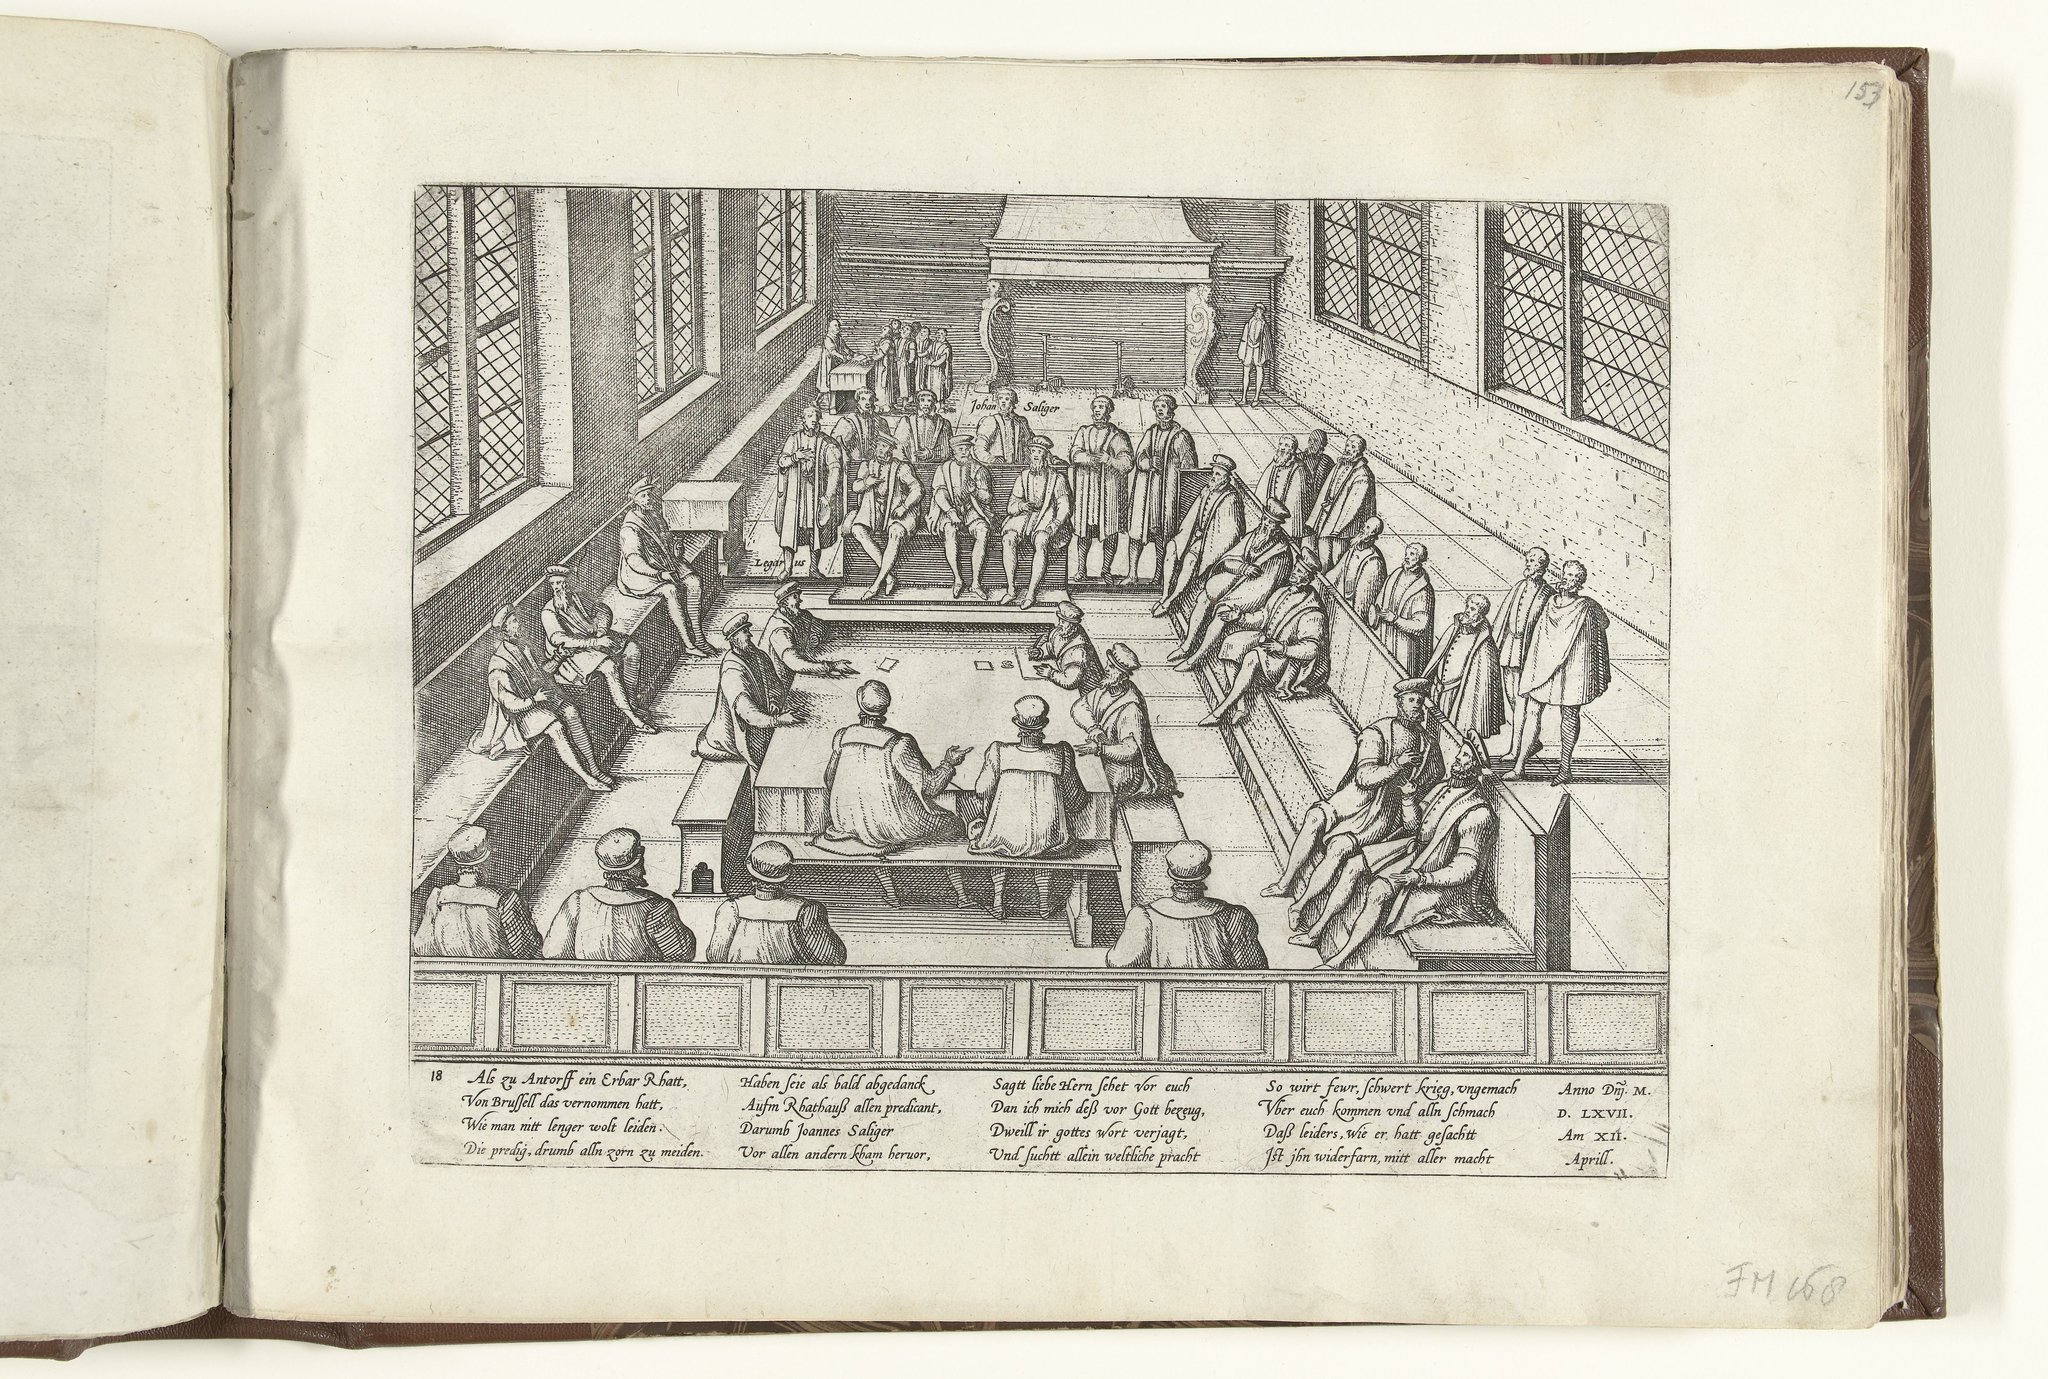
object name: print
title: Verbod op protestantse prediking te Antwerpen, 1577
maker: frans hogenberg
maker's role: print maker, publisher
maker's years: 1538-1590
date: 1577-1579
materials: paper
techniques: etching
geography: cologne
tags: johannes saliger, stadhuis, tachtigjarige oorlog, reformatie, eeuwig edict (1577)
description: Verbod op protestantse prediking te Antwerpen, 12 april 1577. Op het stadhuis wordt tijdens een vergadering aan de vertegenwoordigers van de protestanten in de stad Antwerpen, waaronder Johannes Saliger, bekend gemaakt dat volgens de bepalingen van het Eeuwig Edict protestantse diensten voortaan verboden zijn. Met onderschrift van 16 regels in het Duits. Genummerd: 18.